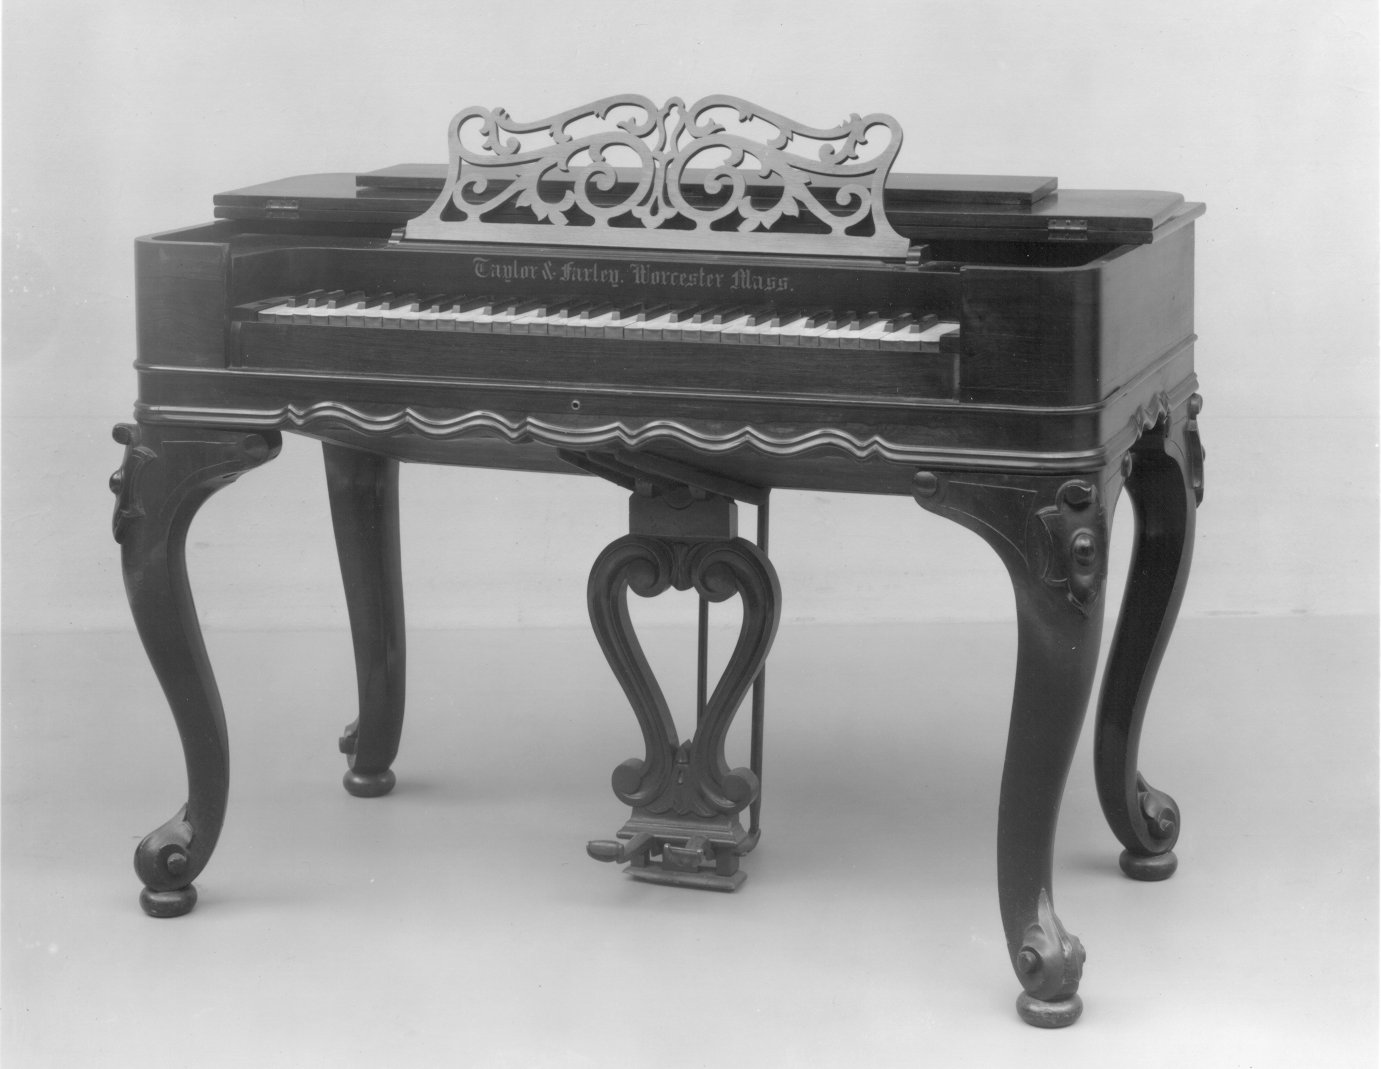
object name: melodeon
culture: american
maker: taylor & farley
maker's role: maker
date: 1867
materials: wood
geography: united states